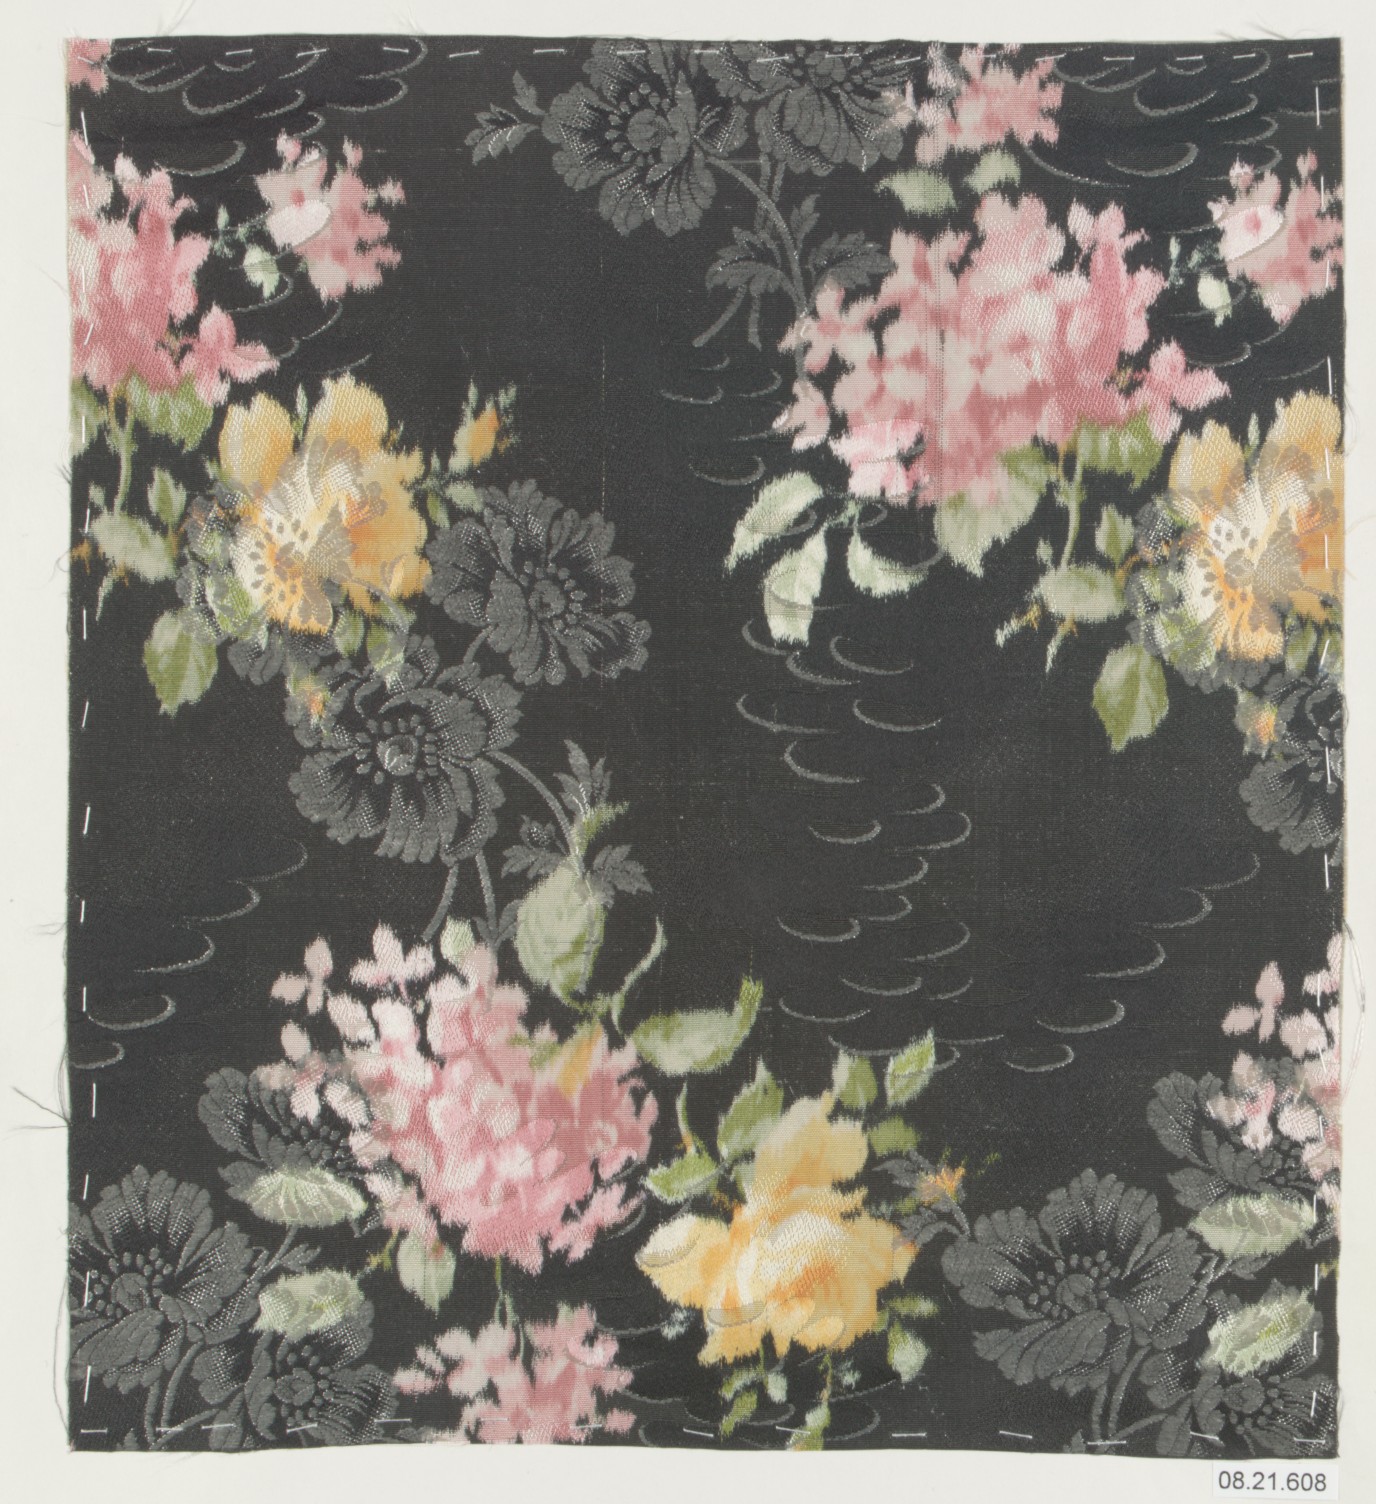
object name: textile sample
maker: Anonymous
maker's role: designer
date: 1900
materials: silk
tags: flowers